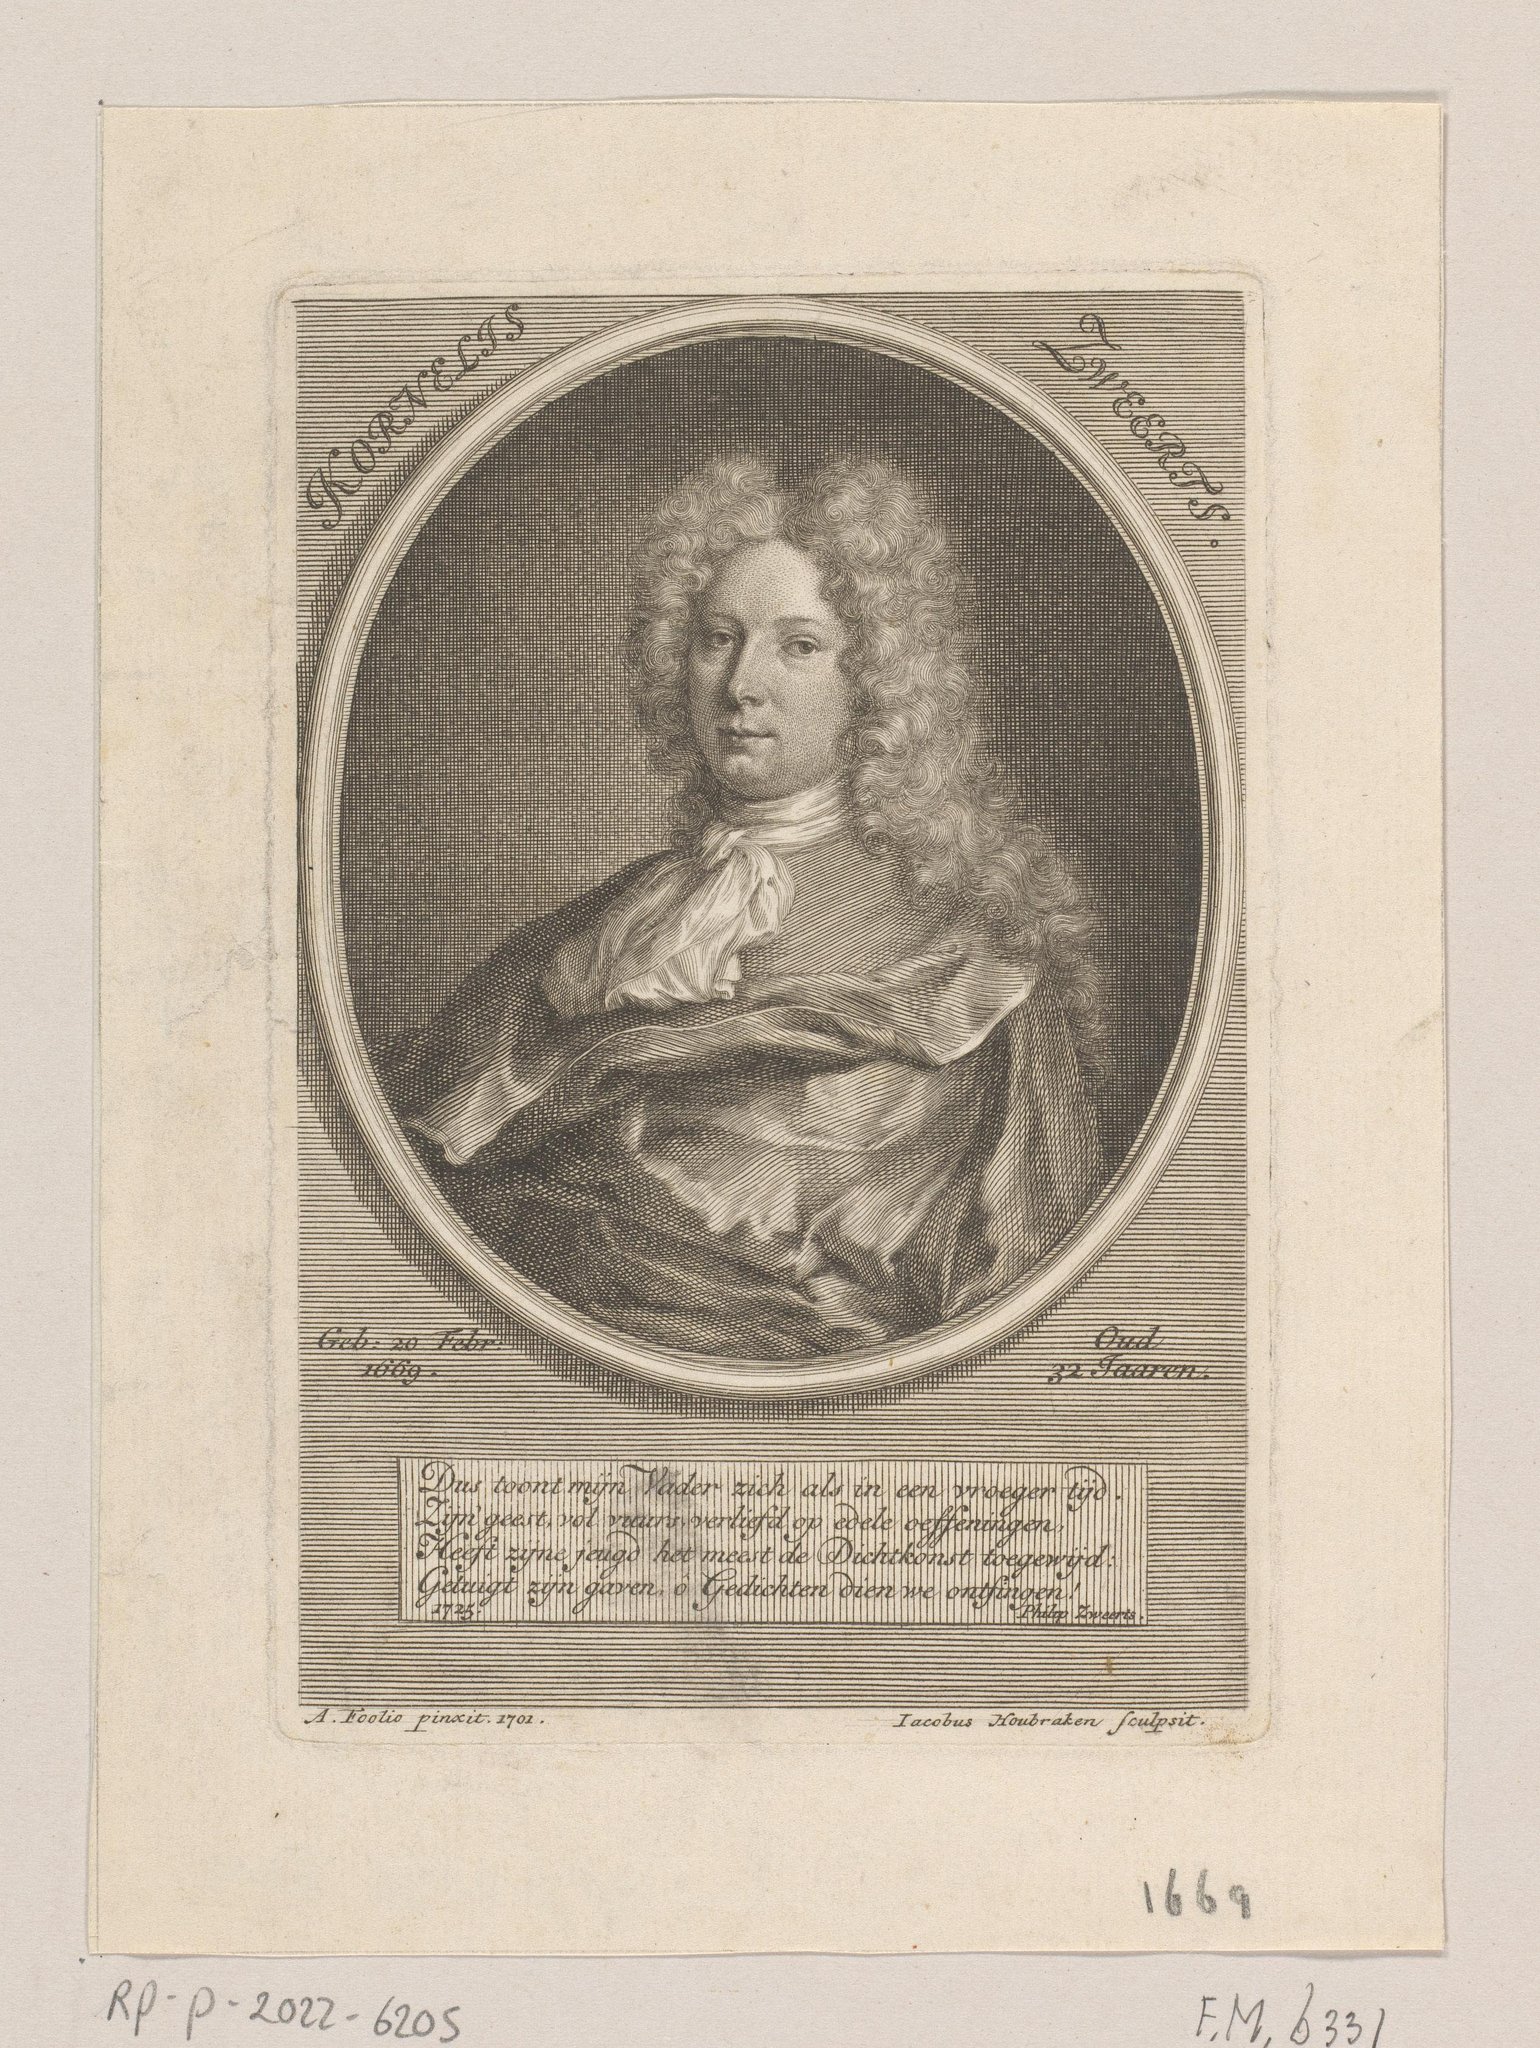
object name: print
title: Portret van Cornelis Sweerts op 32-jarige leeftijd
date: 1725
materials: paper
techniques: engraving, etching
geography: amsterdam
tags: maarssen, cornelis sweerts, historical persons, writer, poet, author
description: Met vierregelig onderschrift in het Nederlands.